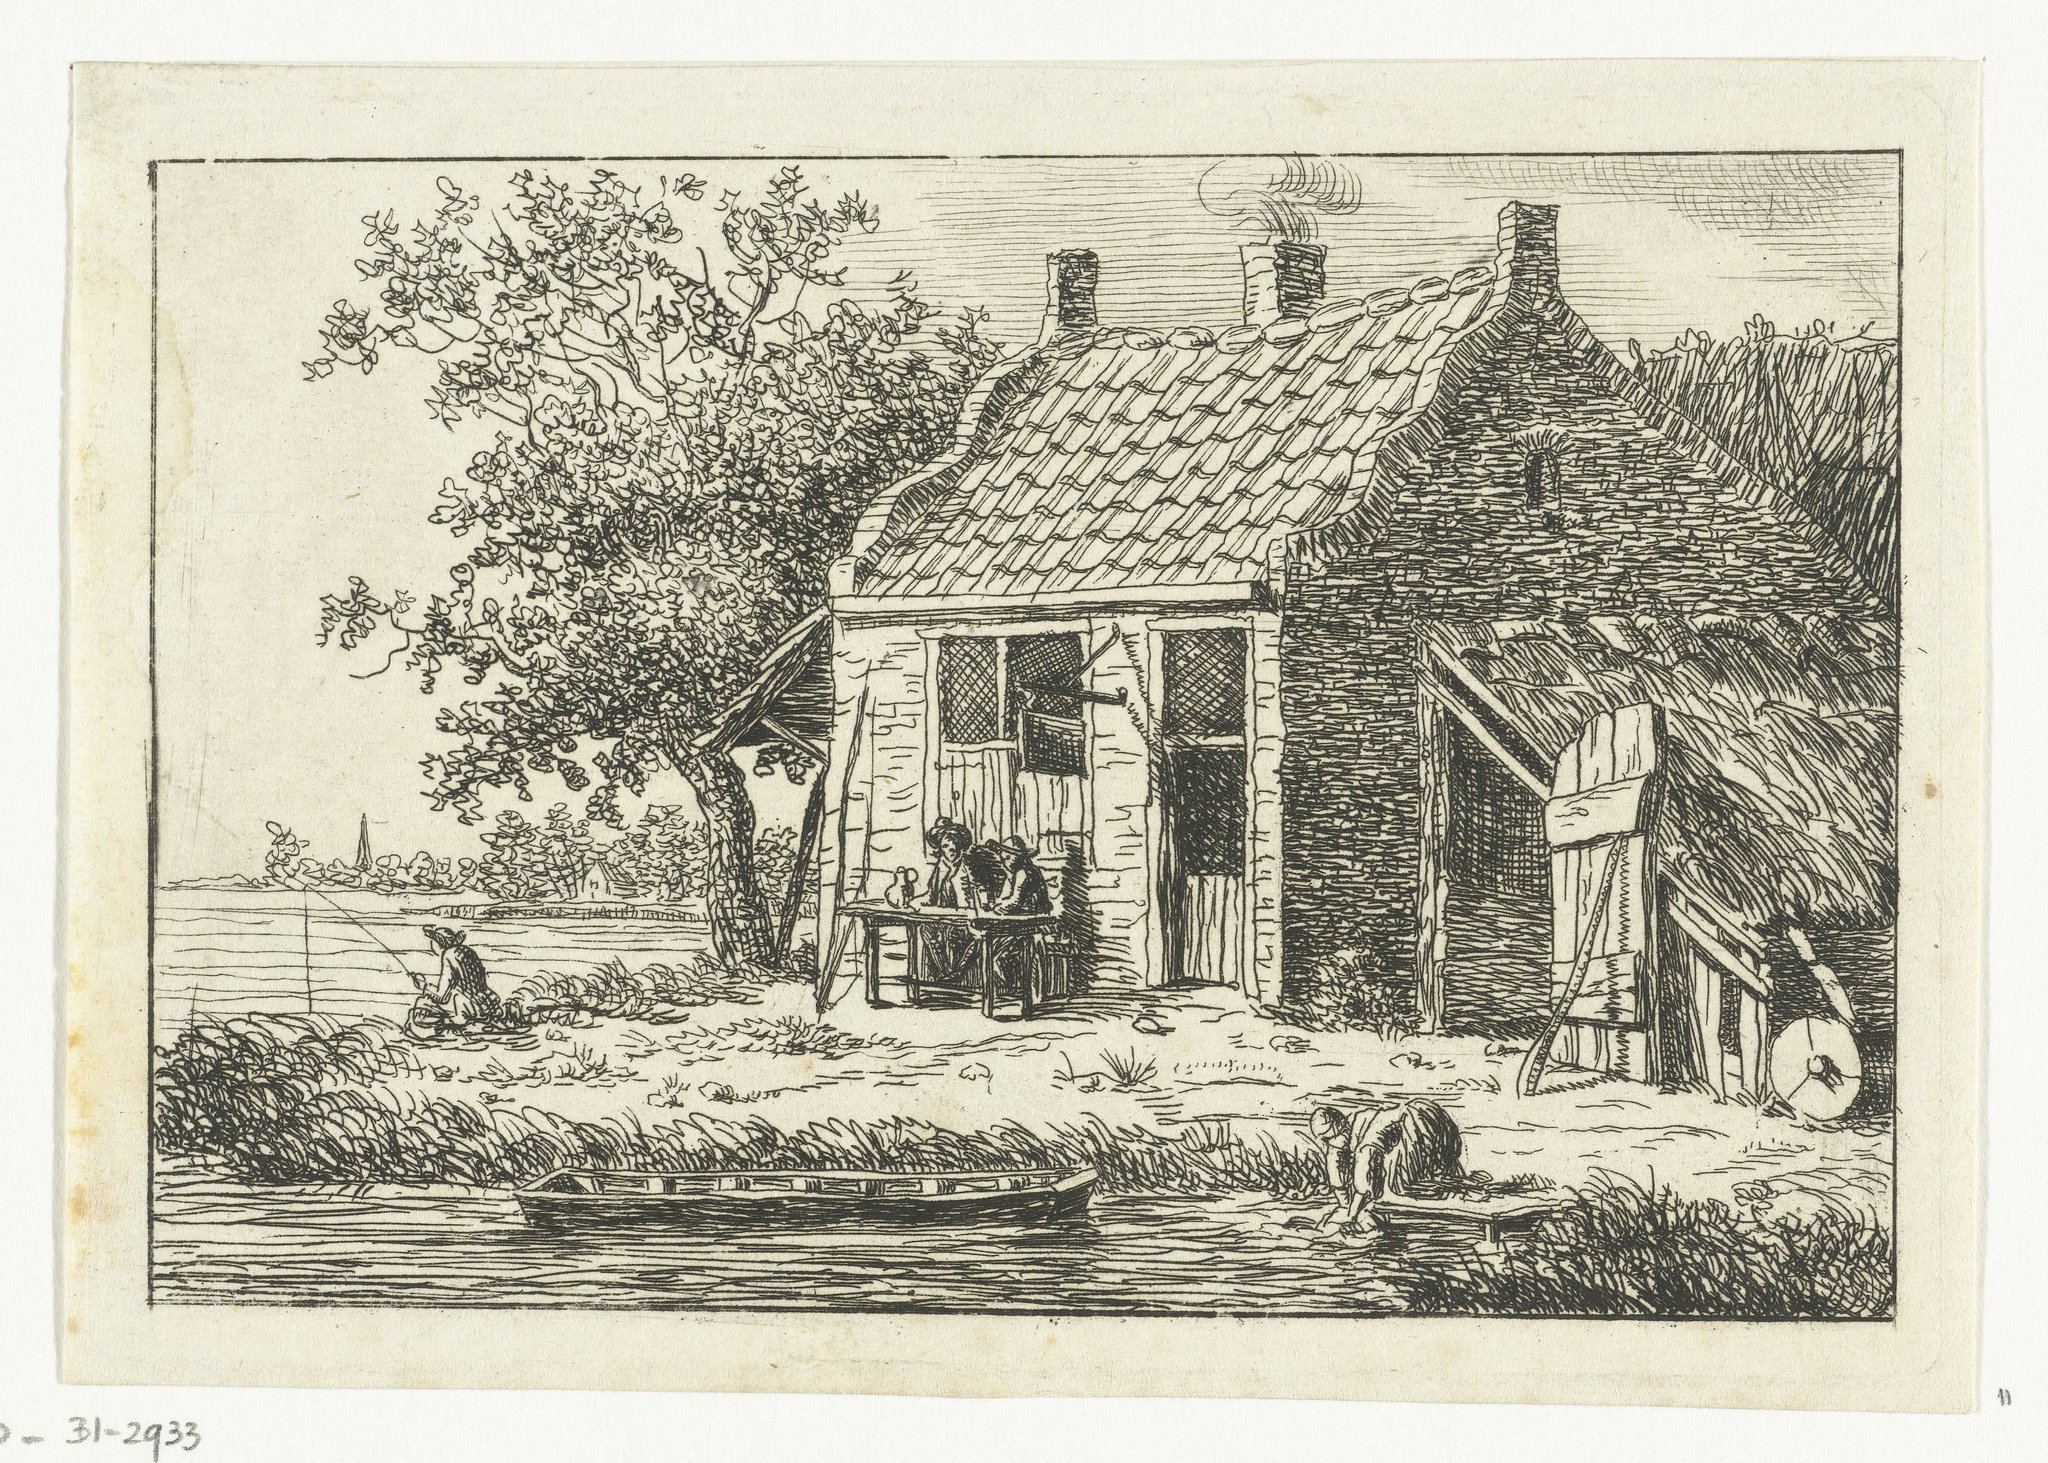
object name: print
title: Herberg aan het water bij Amstelveen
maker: anthonie van den bos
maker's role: draughtsman, print maker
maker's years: 1763-1838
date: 1778-1838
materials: paper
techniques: etching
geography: netherlands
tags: hotel, hostelry, inn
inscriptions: collector's mark: Lugt 2228